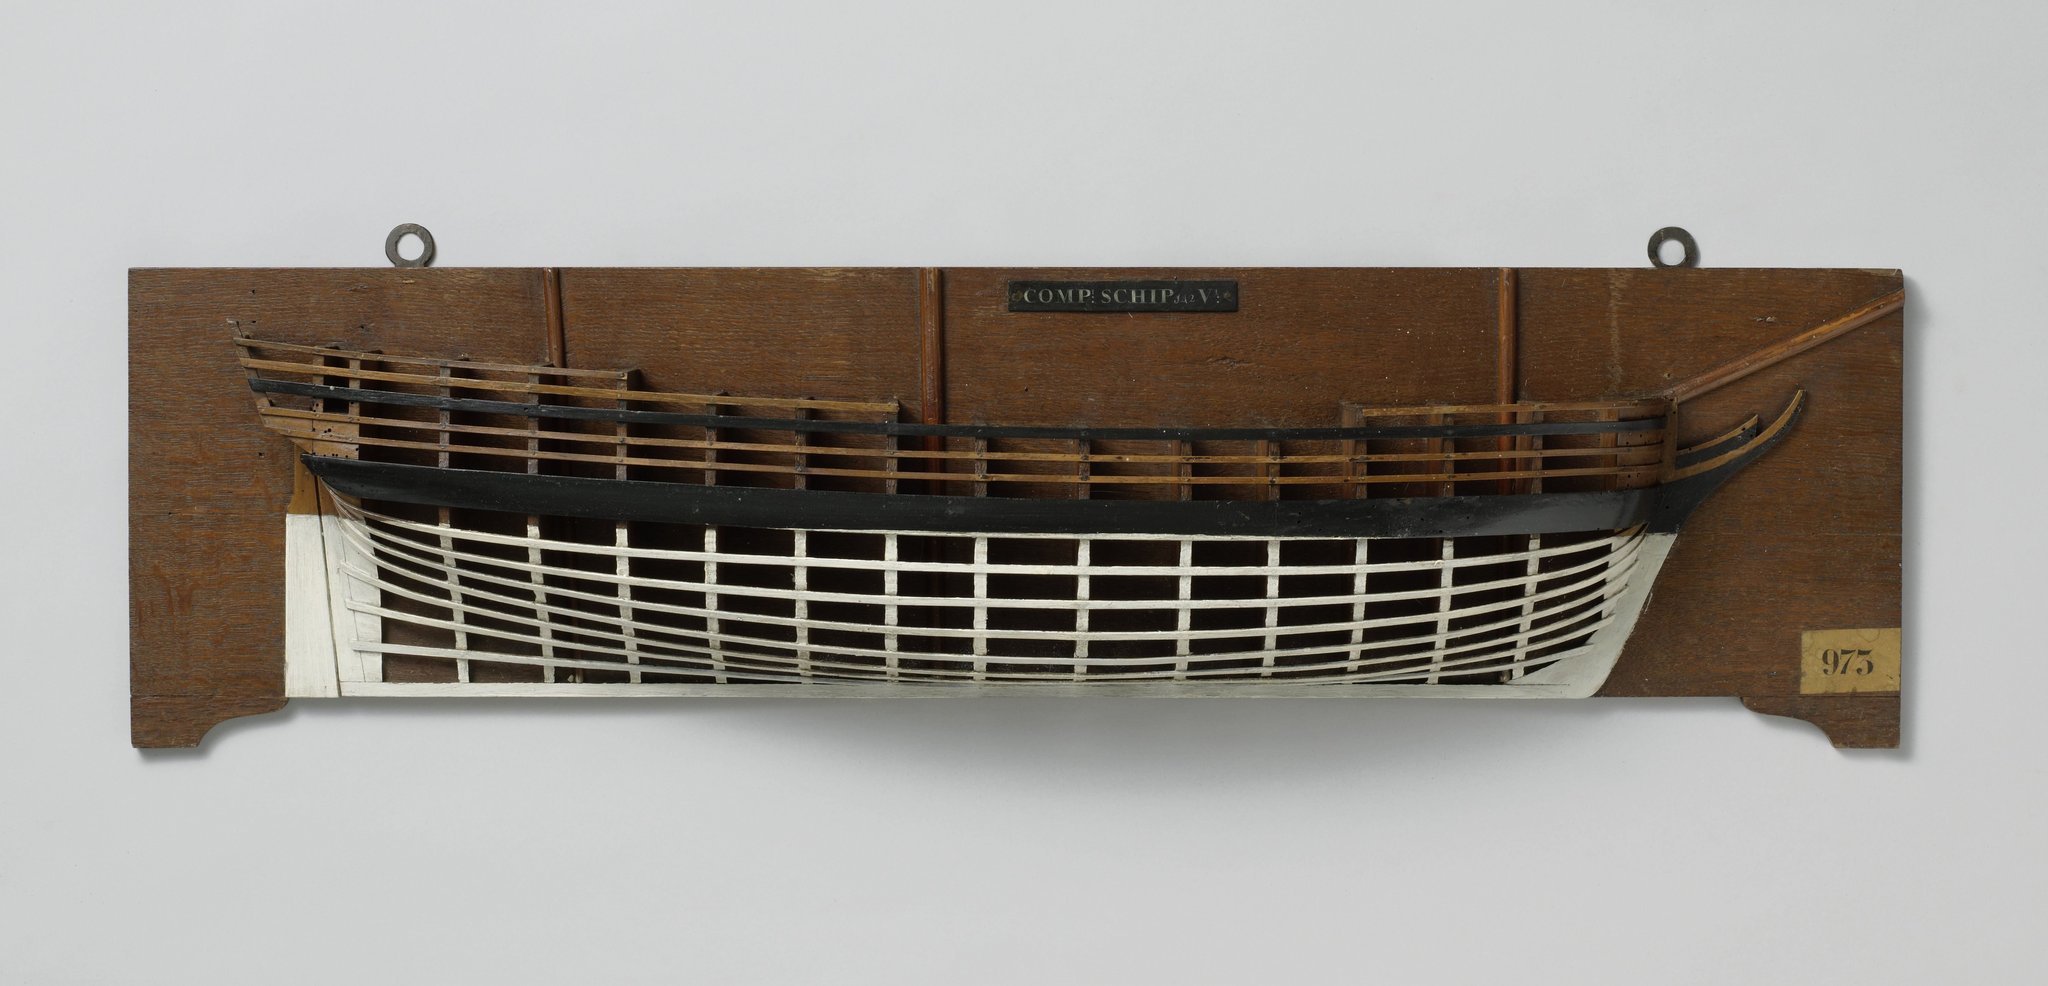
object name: ship model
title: Half Model of an East Indiaman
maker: Anonymous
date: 1775-1795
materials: wood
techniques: polychromy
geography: netherlands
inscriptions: inscription, top centre, on a rectangular black label: ‘COMPi SCHIP 142 Vt:’, label, bottom right: ‘973’ former inventory label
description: Gepolychromeerd mallenmodel (stuurboord) van een driemaster. Geen dekken of geschutpoorten aangegeven, halfdek en bakdek kunnen door de gillingen worden onderscheiden. Gewrongen spiegel, hol wulf, geen details van hek of zijgalerij; recht roer met vierkante roerkoning. Zeeg naar voren en naar achter oplopend, één barkhout en één reehout. Gepiekt rondspant. Schaal ca. 1:60 (afgeleid).